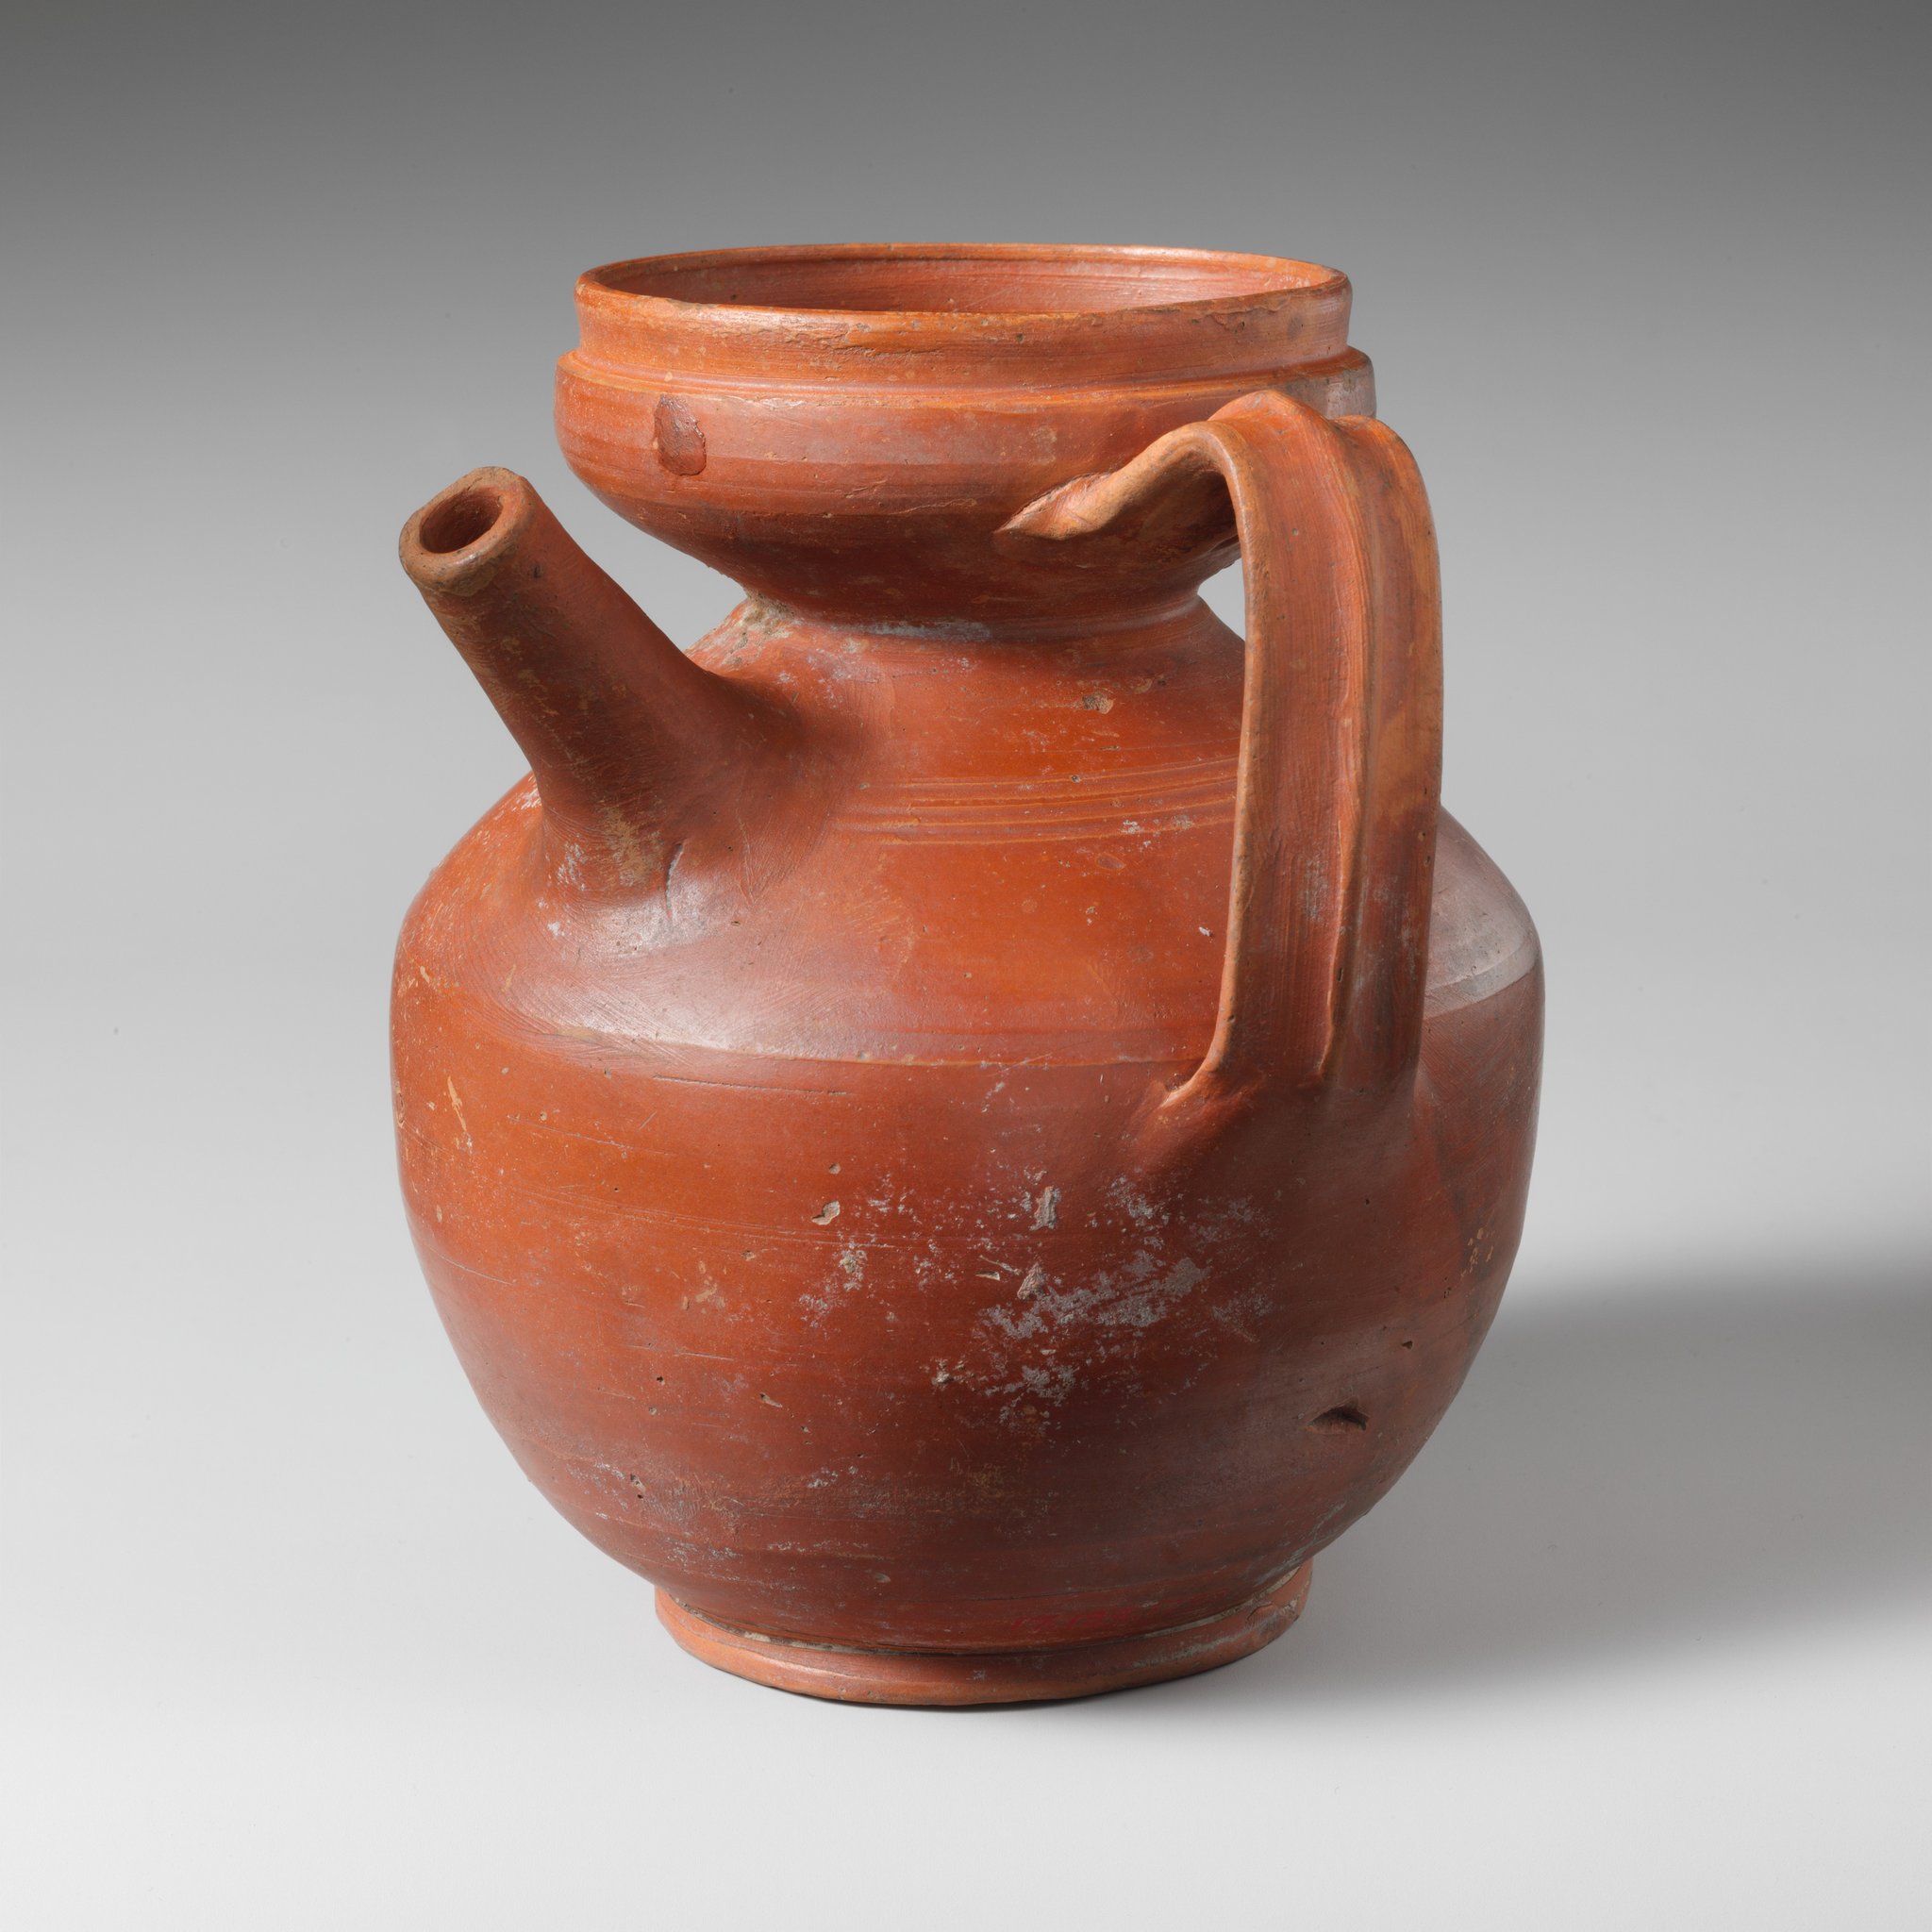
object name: vase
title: Terracotta strainer jug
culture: roman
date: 1-100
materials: terracotta